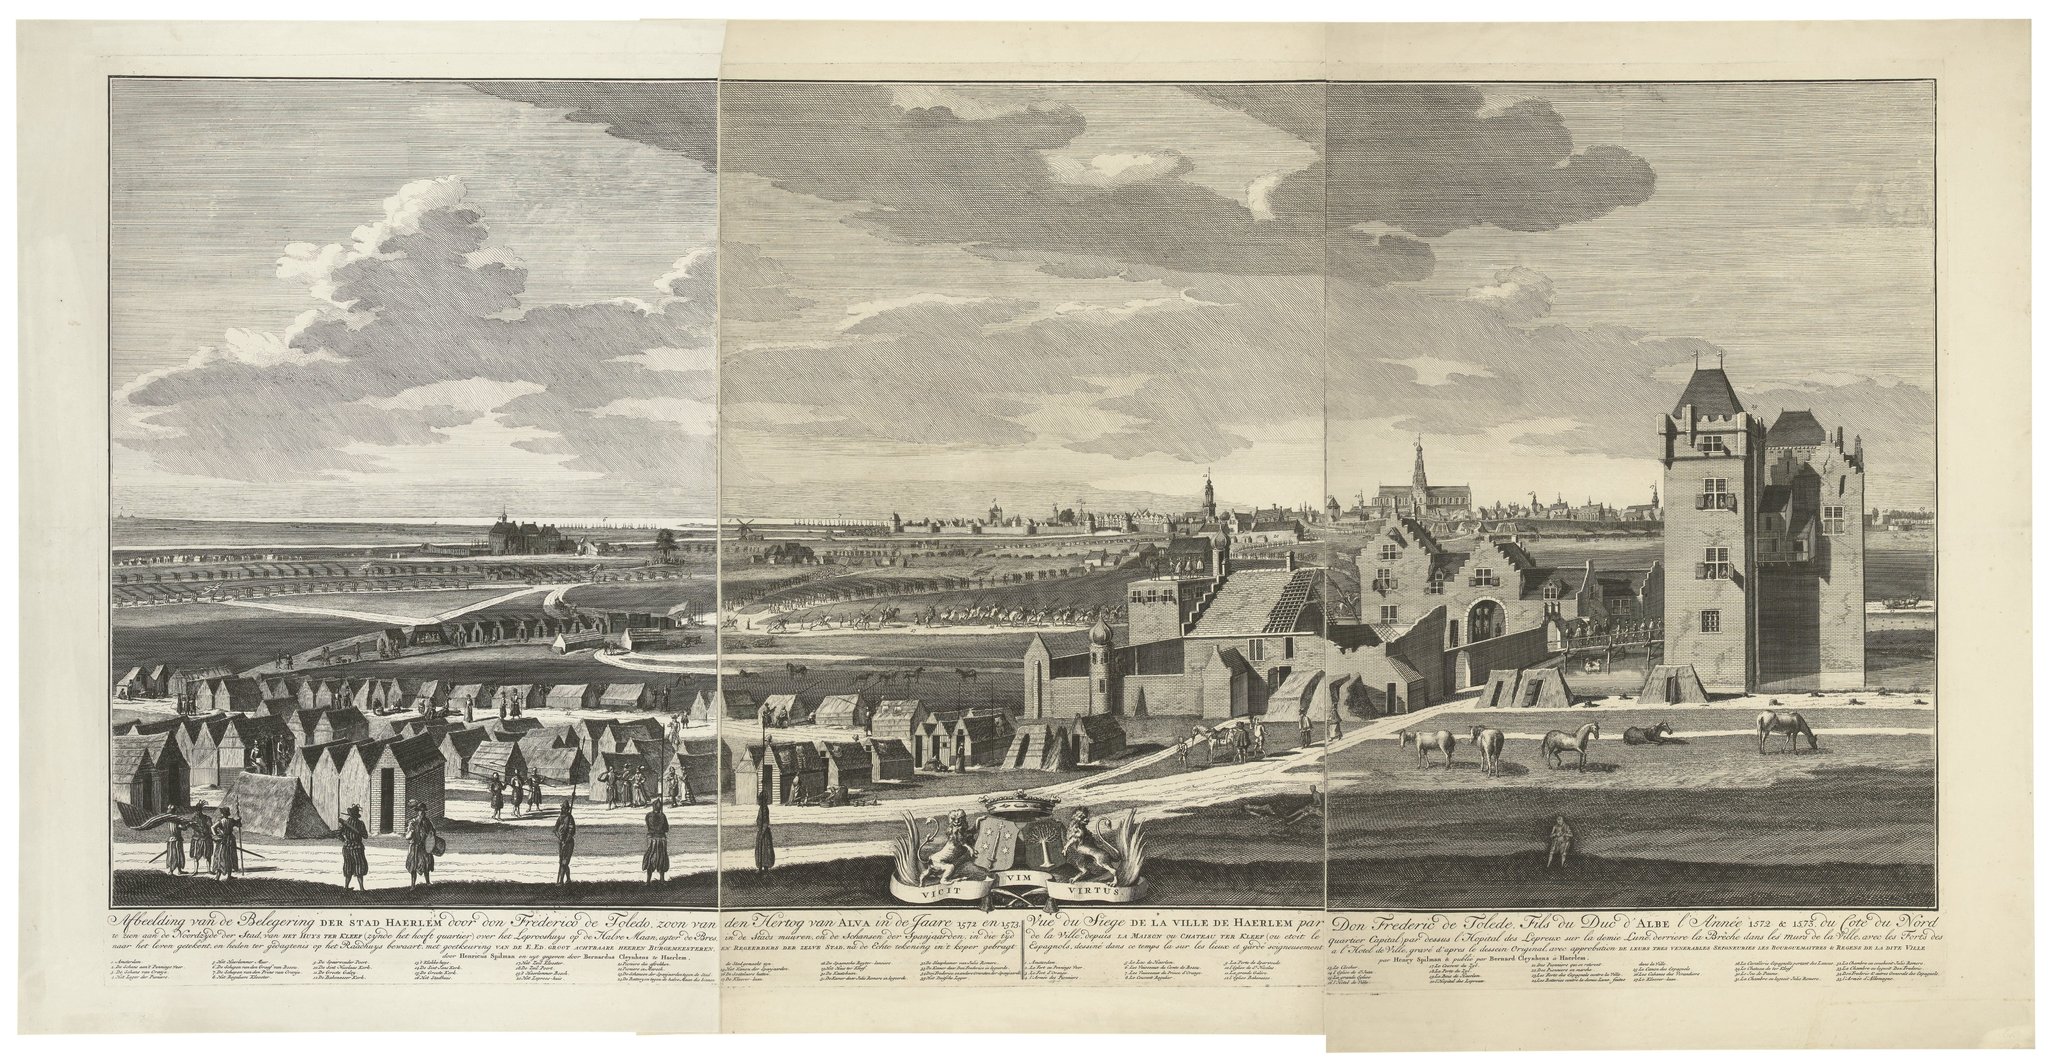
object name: print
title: Afbeelding van de Belegering der stad Haerlem door don Frederico de Toledo, zoon van den Hertog van Alva in de jaare 1572 en 1573, te zien aan de noordzyde der stad, van het Huys ter Kleef (zynde het hooft quartier) over het Leprooshuys op de Halve Maan, agter de Bres, in de stads muuren, en de schansen der Spanjaarden, in die tijd naar het leven getekent (...) / Vue du Siege de la ville de Haerlem par Don Frederic de Tolede, fils du Duc d'Albe l'année 1572 & 1573 (...)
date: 1742-1779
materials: paper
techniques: etching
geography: haarlem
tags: siege, position war, haarlem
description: Belegering van de stad Haarlem in de jaren 1572-1573 door de Spanjaarden onder Fadrique Alvarez de Toledo (Don Frederik), de zoon van de hertog van Alva. Grote voorstelling met een gezicht op de stad vanuit het noorden, in prent naar een eigentijdse tekening in drie bladen. Onder in het midden het wapen van Haarlem. Rechts het Huis ter Kleef, in de verte de Sint Bavo. Onder de voorstelling de titels en de legenda's 1-35 in het Nederlands en Frans.